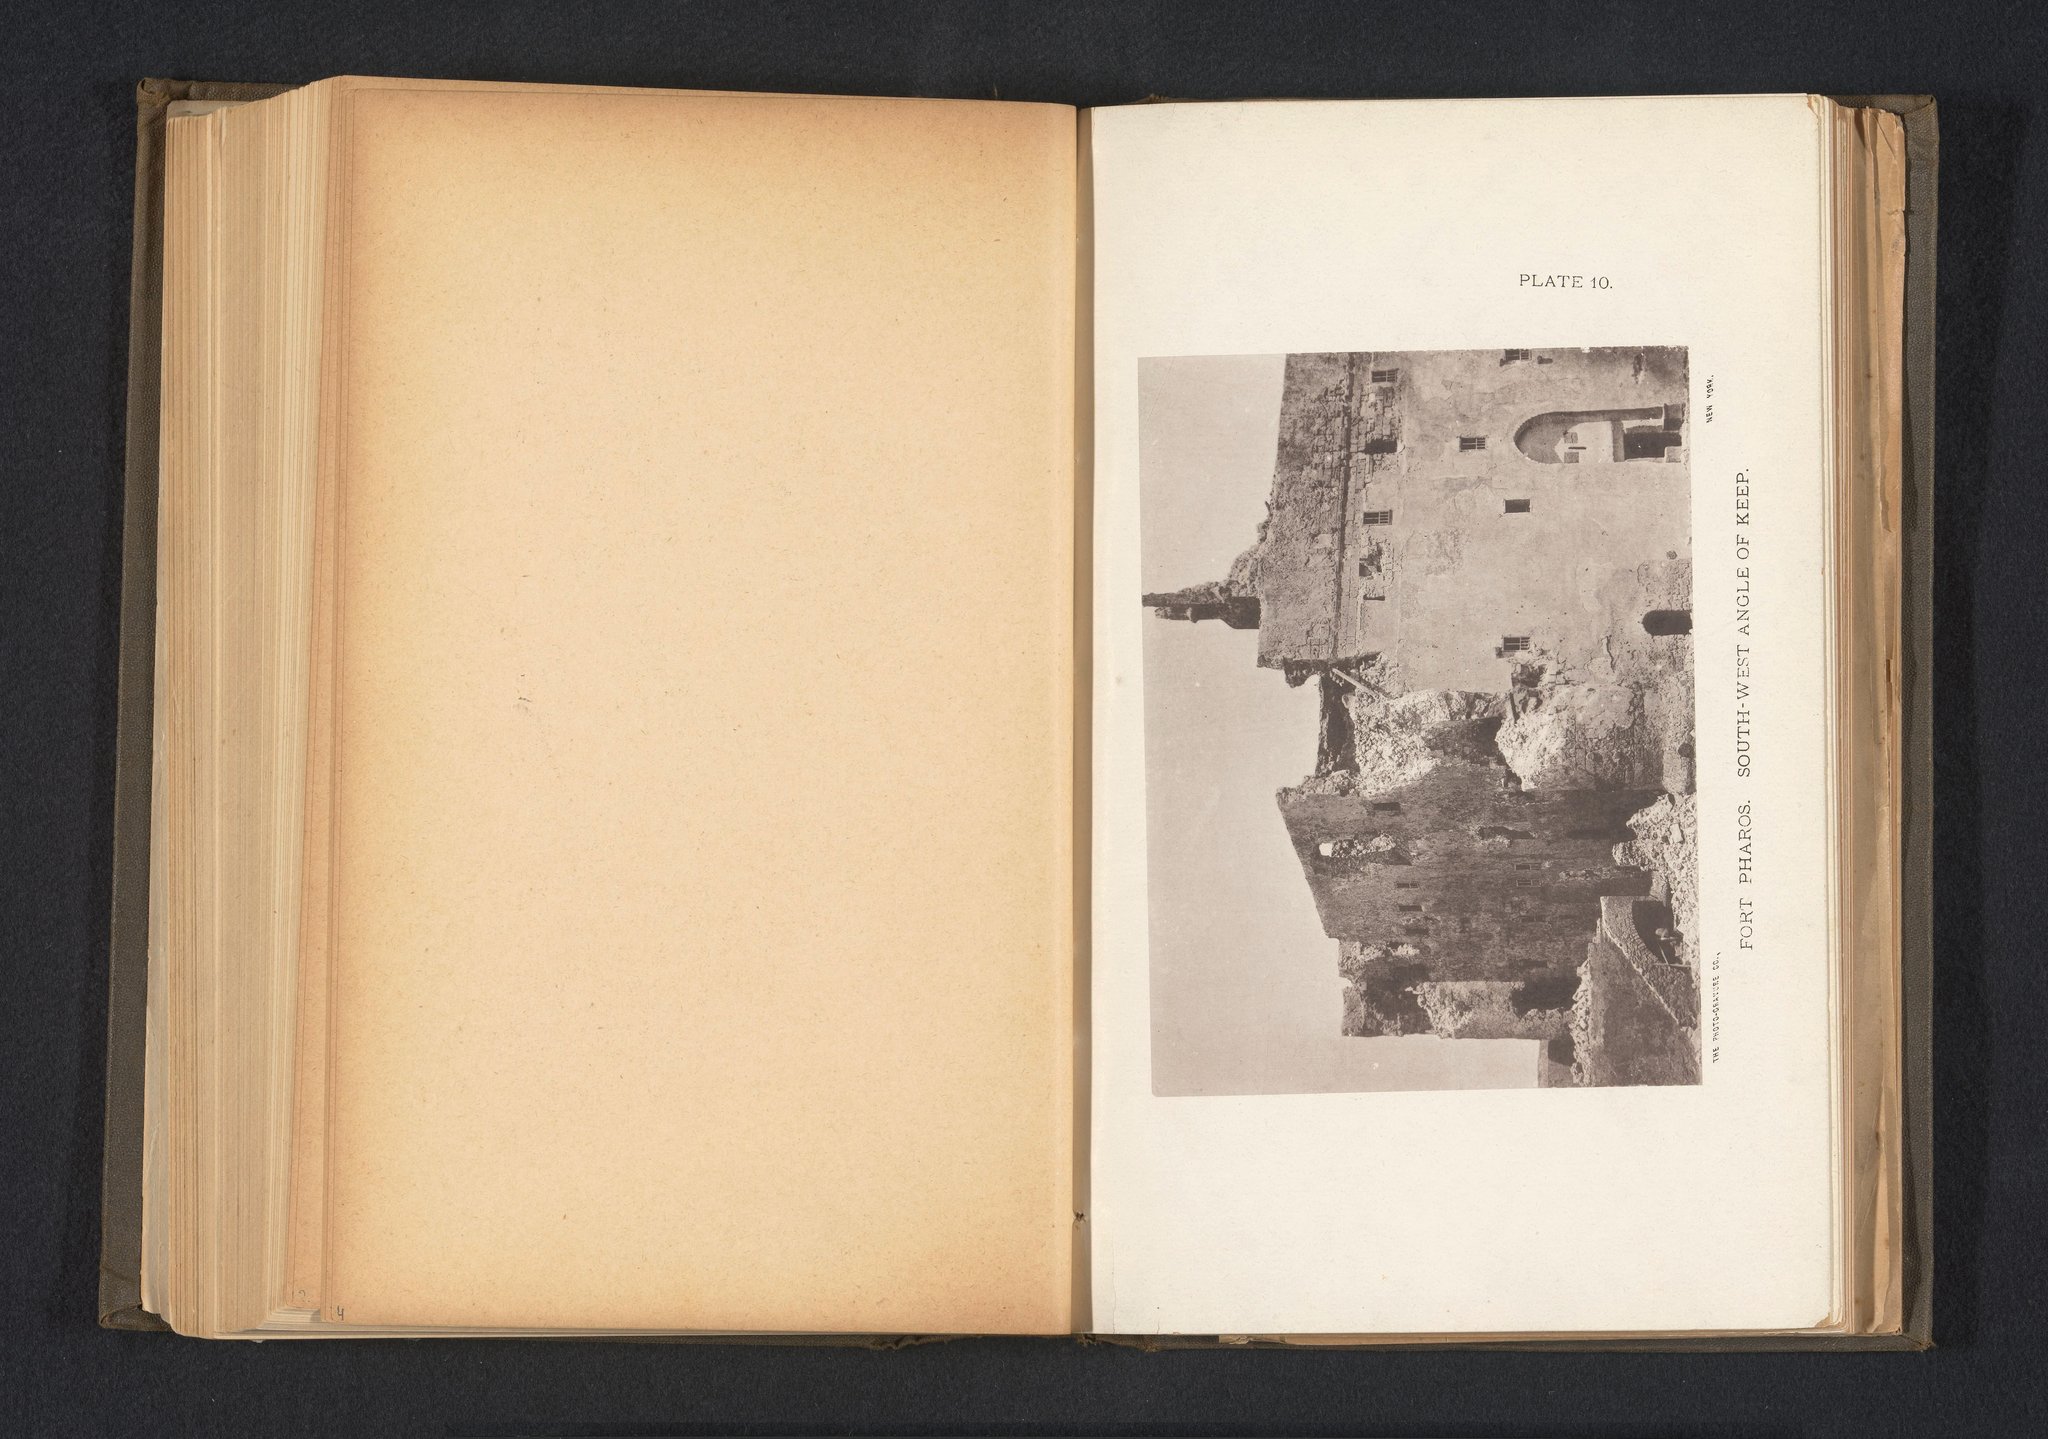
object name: page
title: Gezicht op het exterieur van het fort op Pharos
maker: Anonymous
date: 1882-1885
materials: paper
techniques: photograph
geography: new york city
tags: fortress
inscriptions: number: ‘Plate 10.’